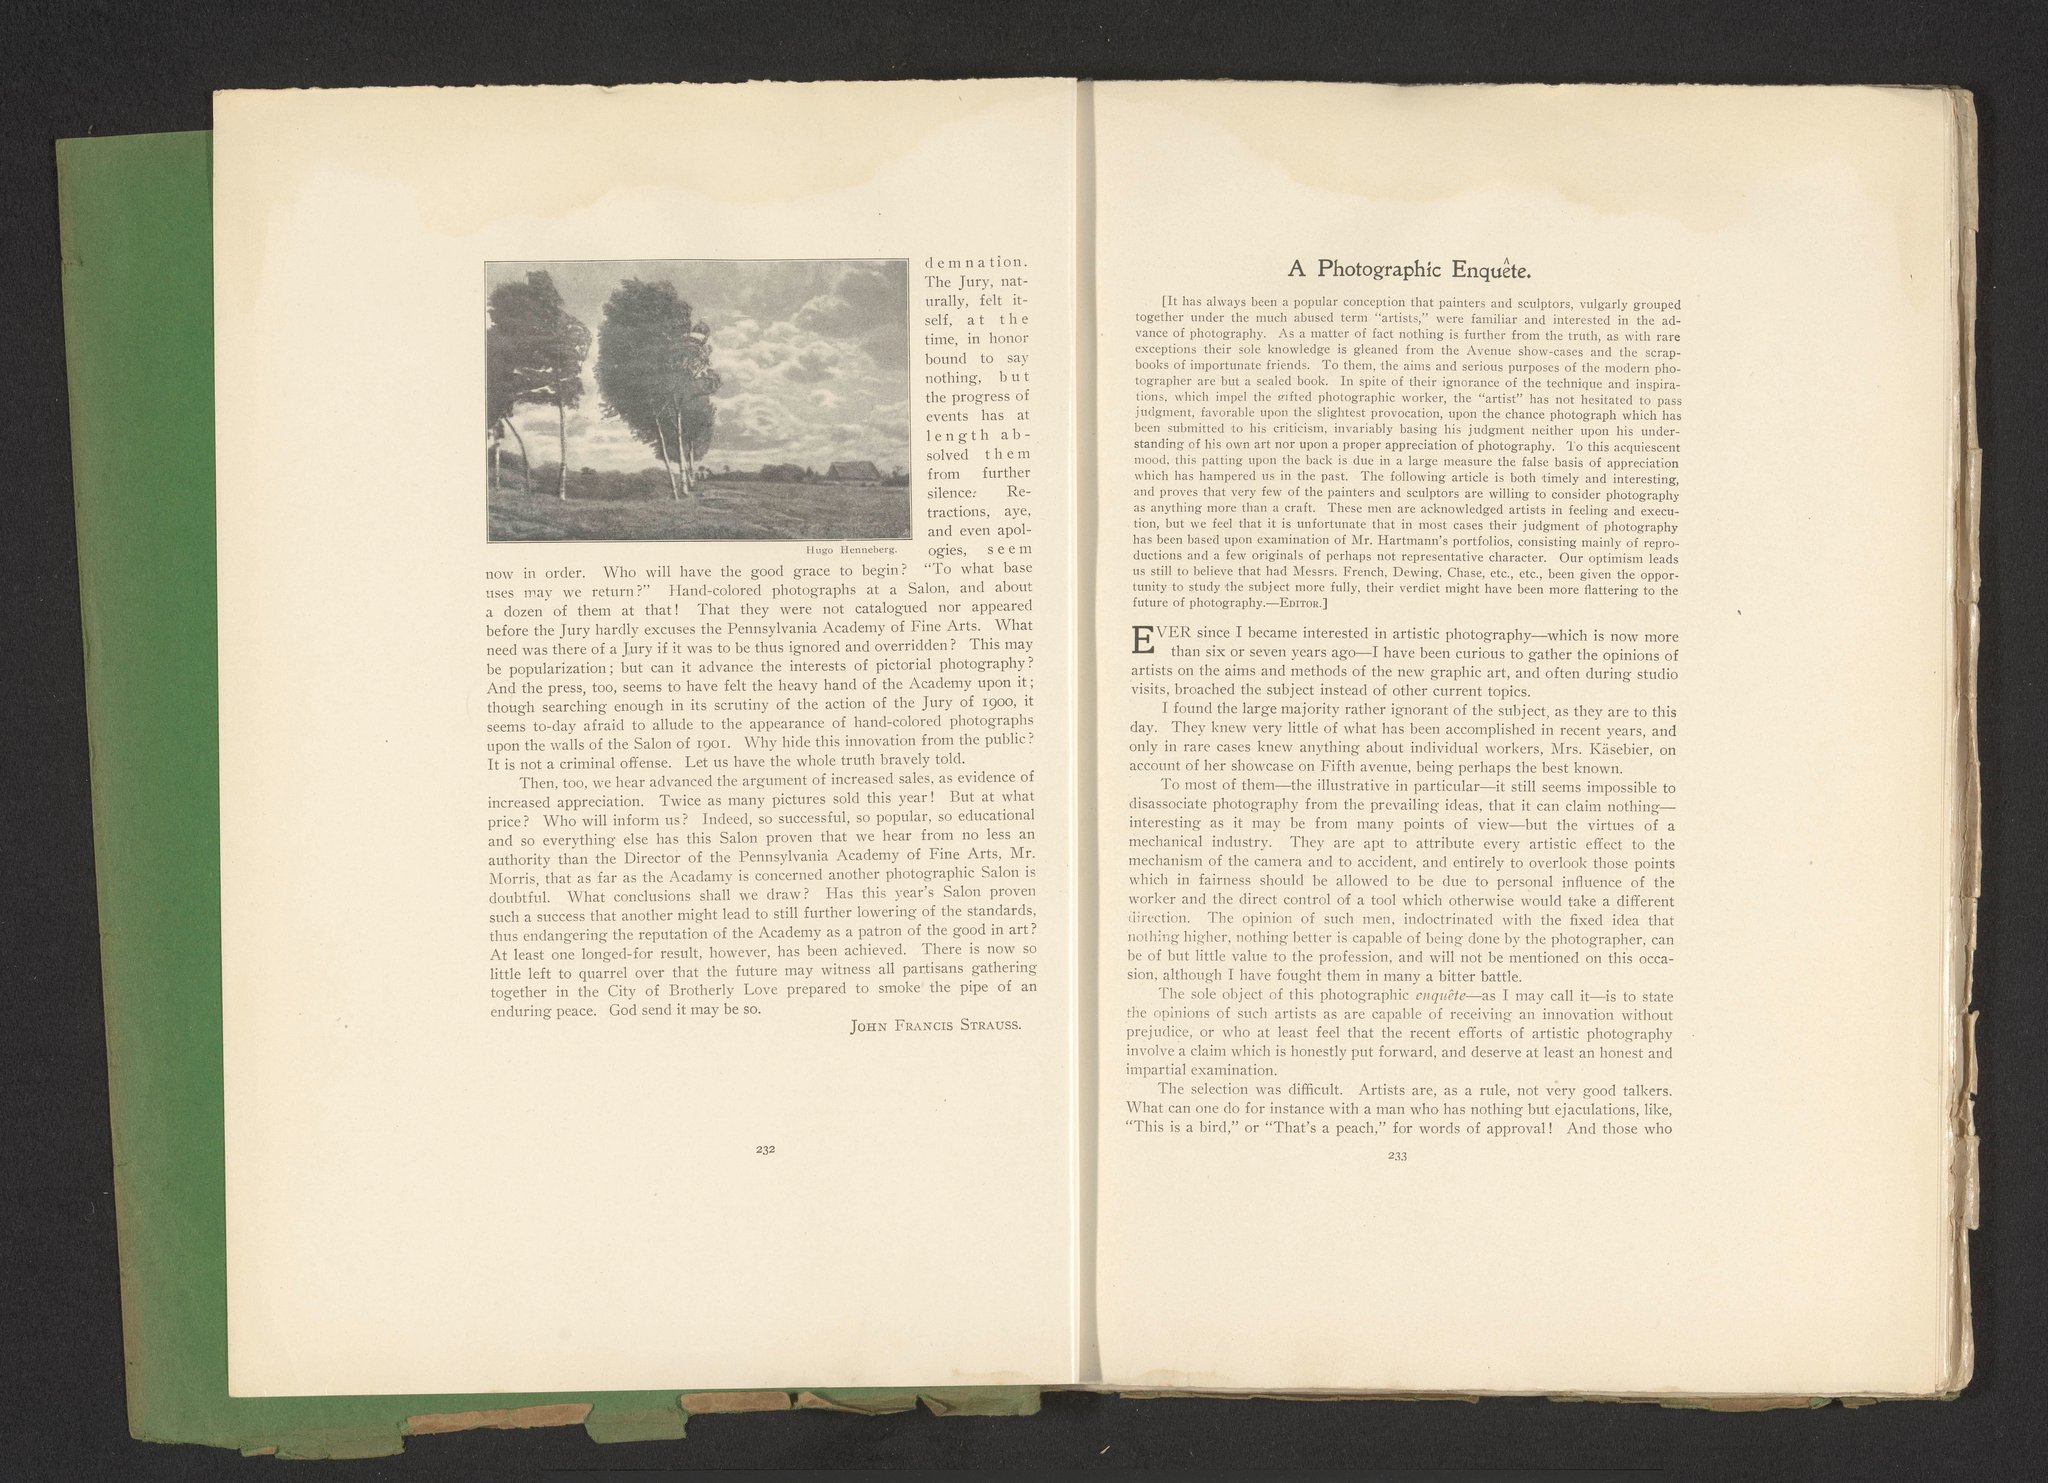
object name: photomechanical print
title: Landschap met bomen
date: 1897-1902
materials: paper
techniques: autotype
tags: trees, landscapes